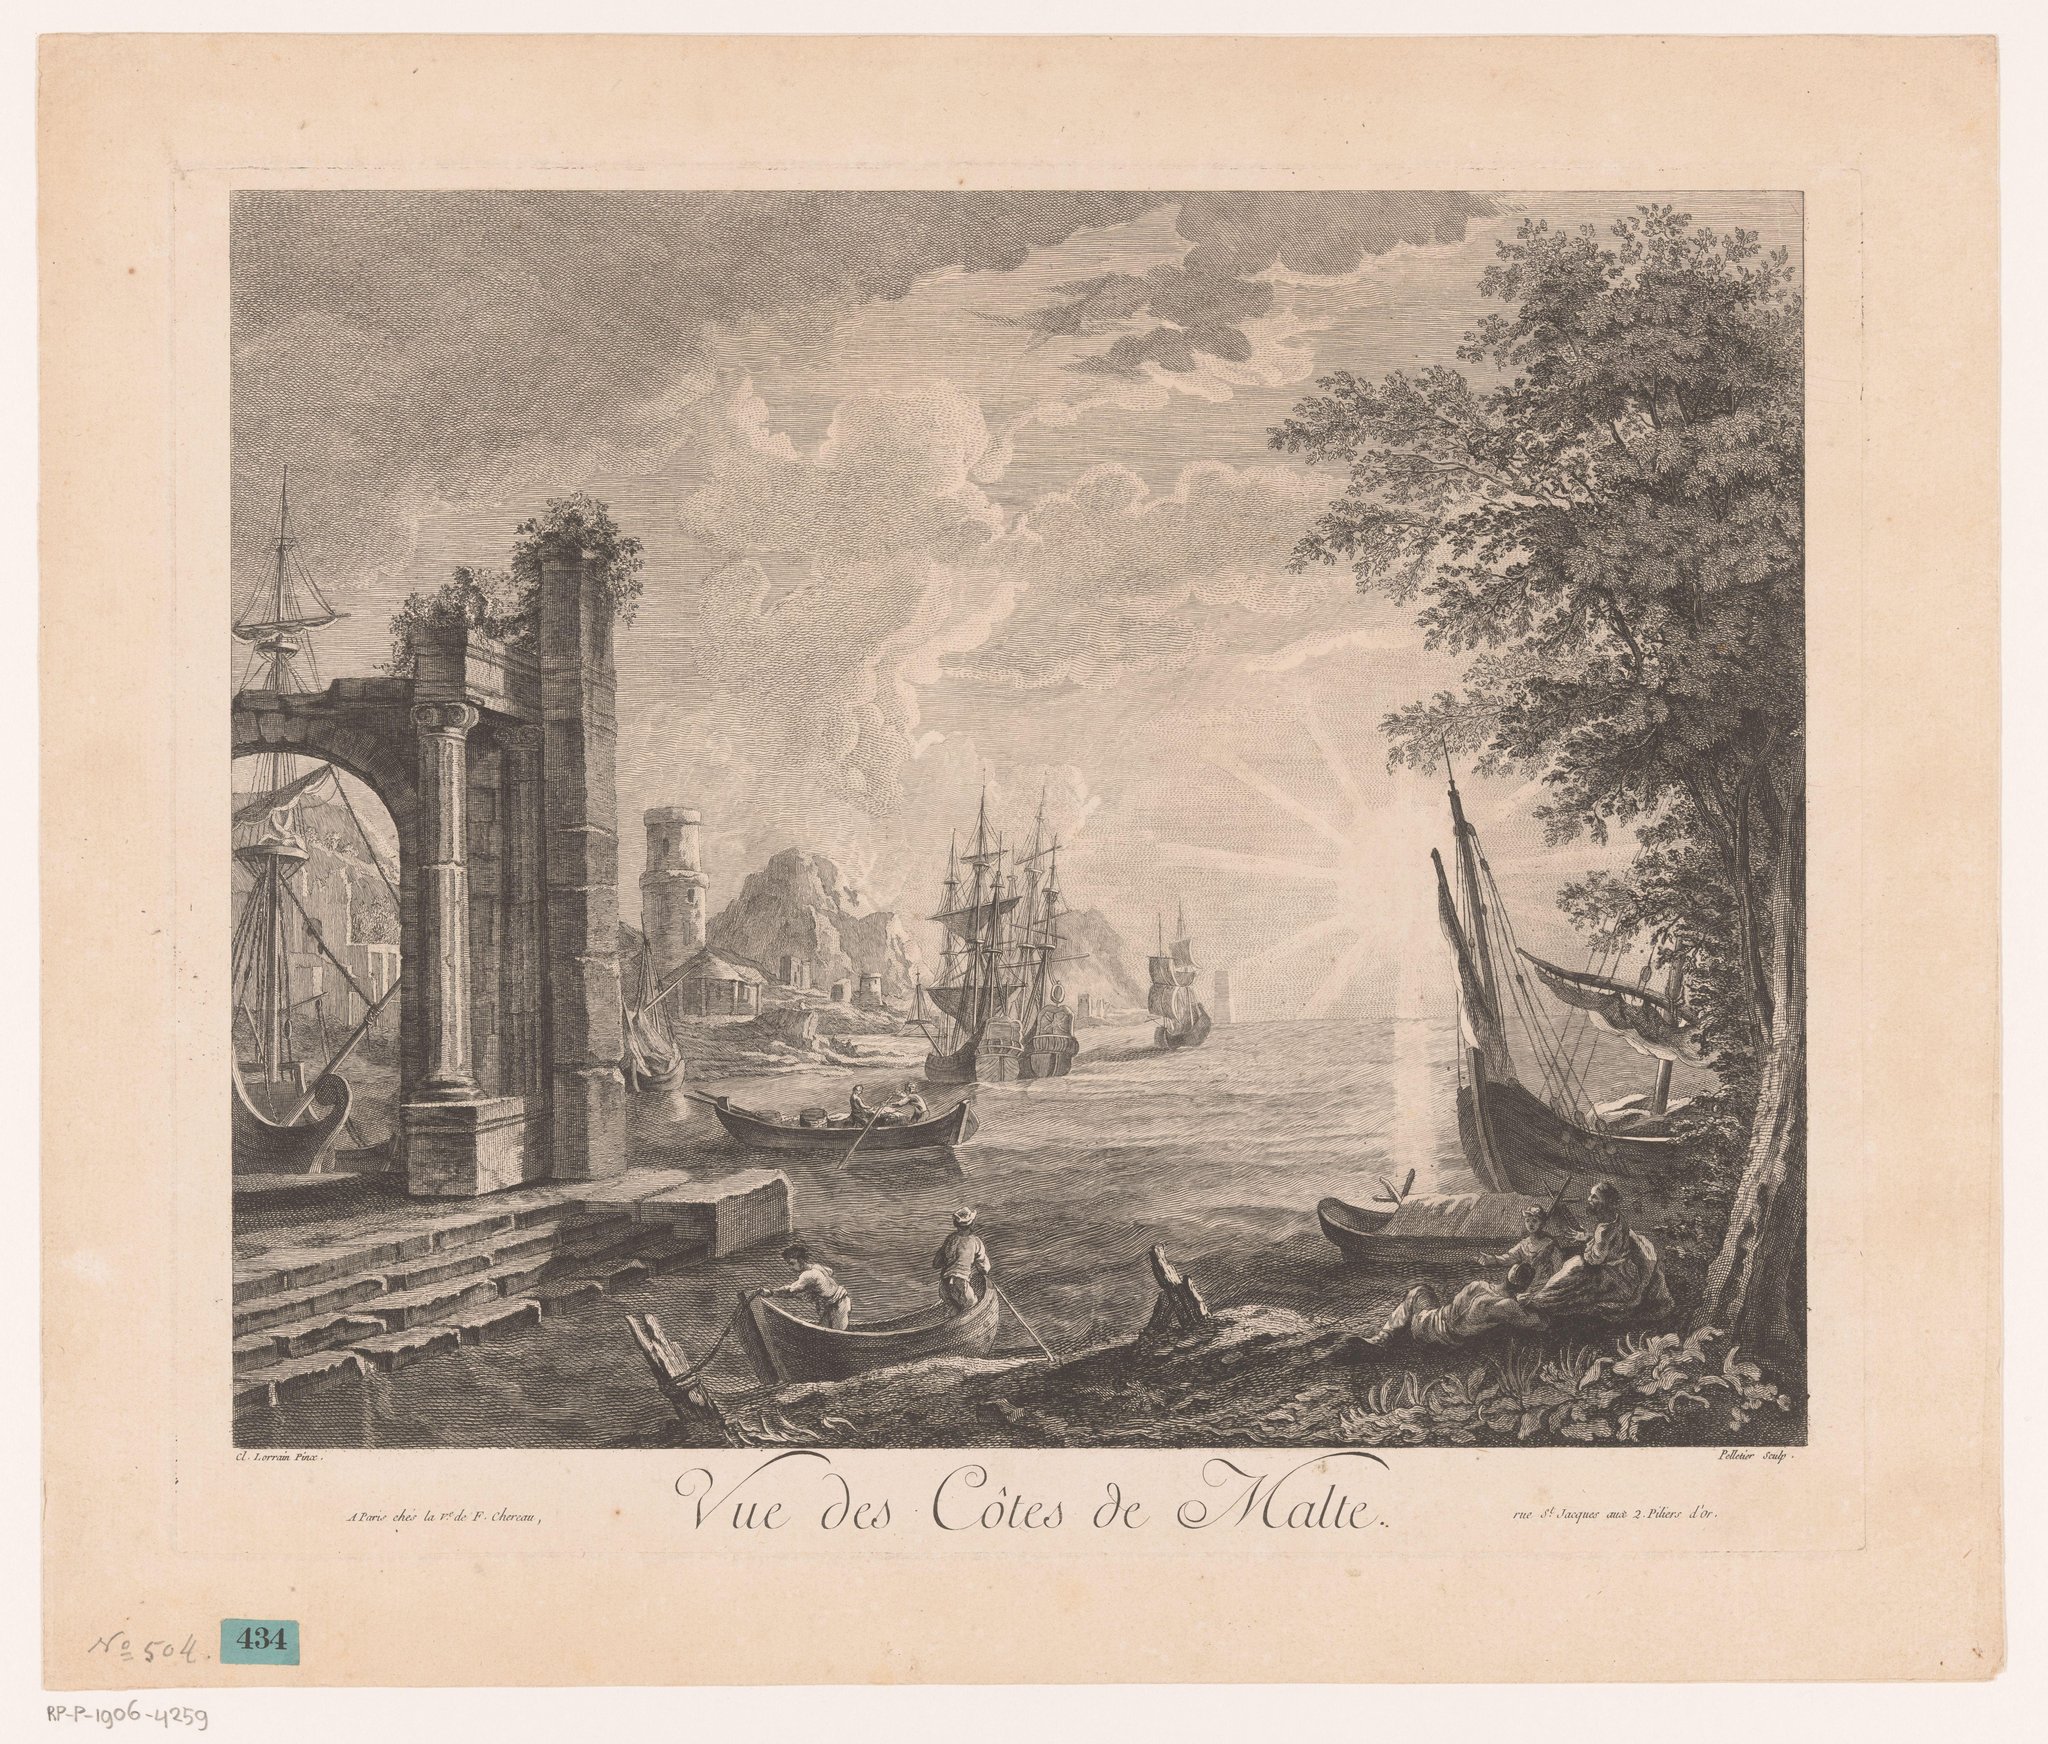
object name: print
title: Vue des Côtes de Malte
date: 1746-1780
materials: paper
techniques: engraving, etching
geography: paris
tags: coast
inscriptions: collector's mark: Lugt 2028, number: ‘434’, collector's mark: Lugt 2228, number: ‘No. 504’